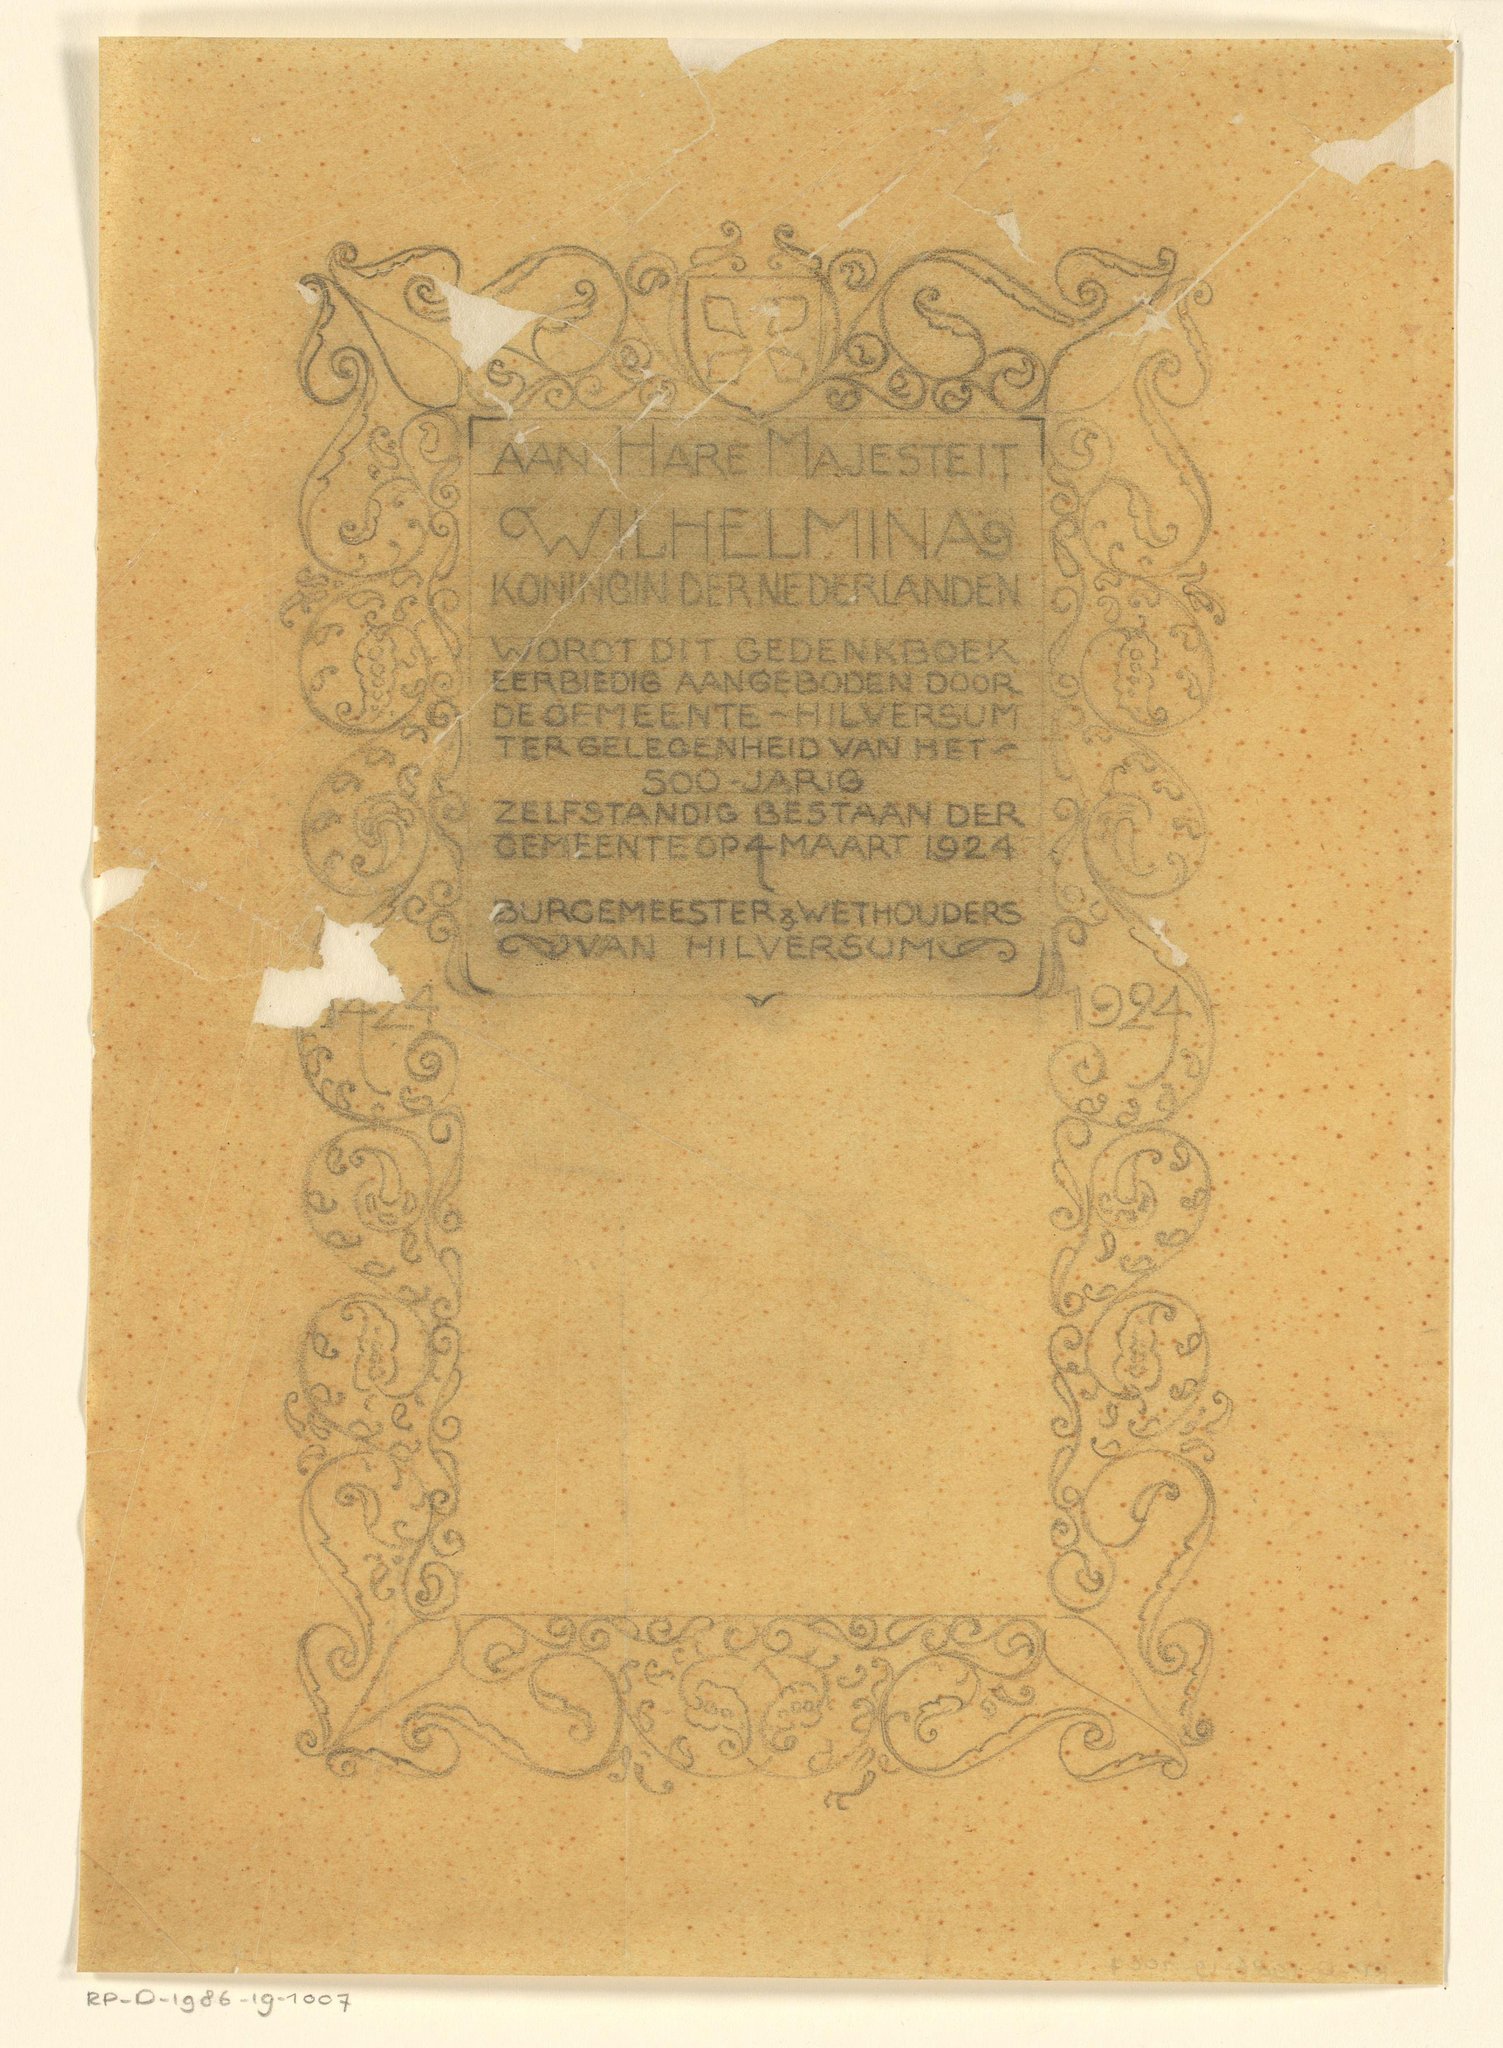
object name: drawing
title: Ontwerp voor een tekstkader voor het Gedenkboek Hilversum 1424-1924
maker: reinier willem petrus de vries (1874-1953)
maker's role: draughtsman, print maker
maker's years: 1874-1953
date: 1924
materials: pencil, paper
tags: coat of arms (as symbol of the state, etc.) (+ city; municipal), flowers ~ ornament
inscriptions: date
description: Rechthoekig kader met bloemornamenten en het wapen van Hilversum. De tekst vermeldt dat het gedenkboek aan koningin Wilhelmina zal worden aangeboden.